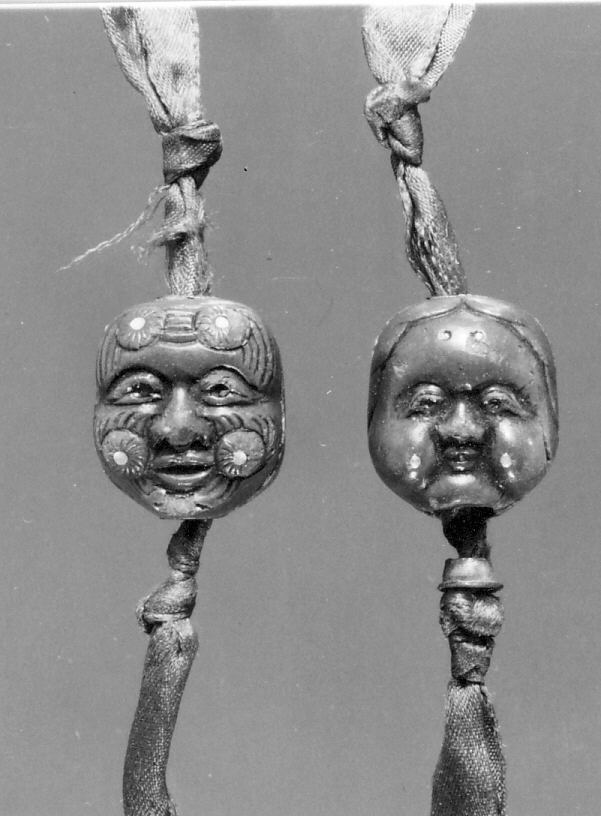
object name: ojime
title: Pair of Ojime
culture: japanese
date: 1801-1933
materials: glass, lacquer, silk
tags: faces